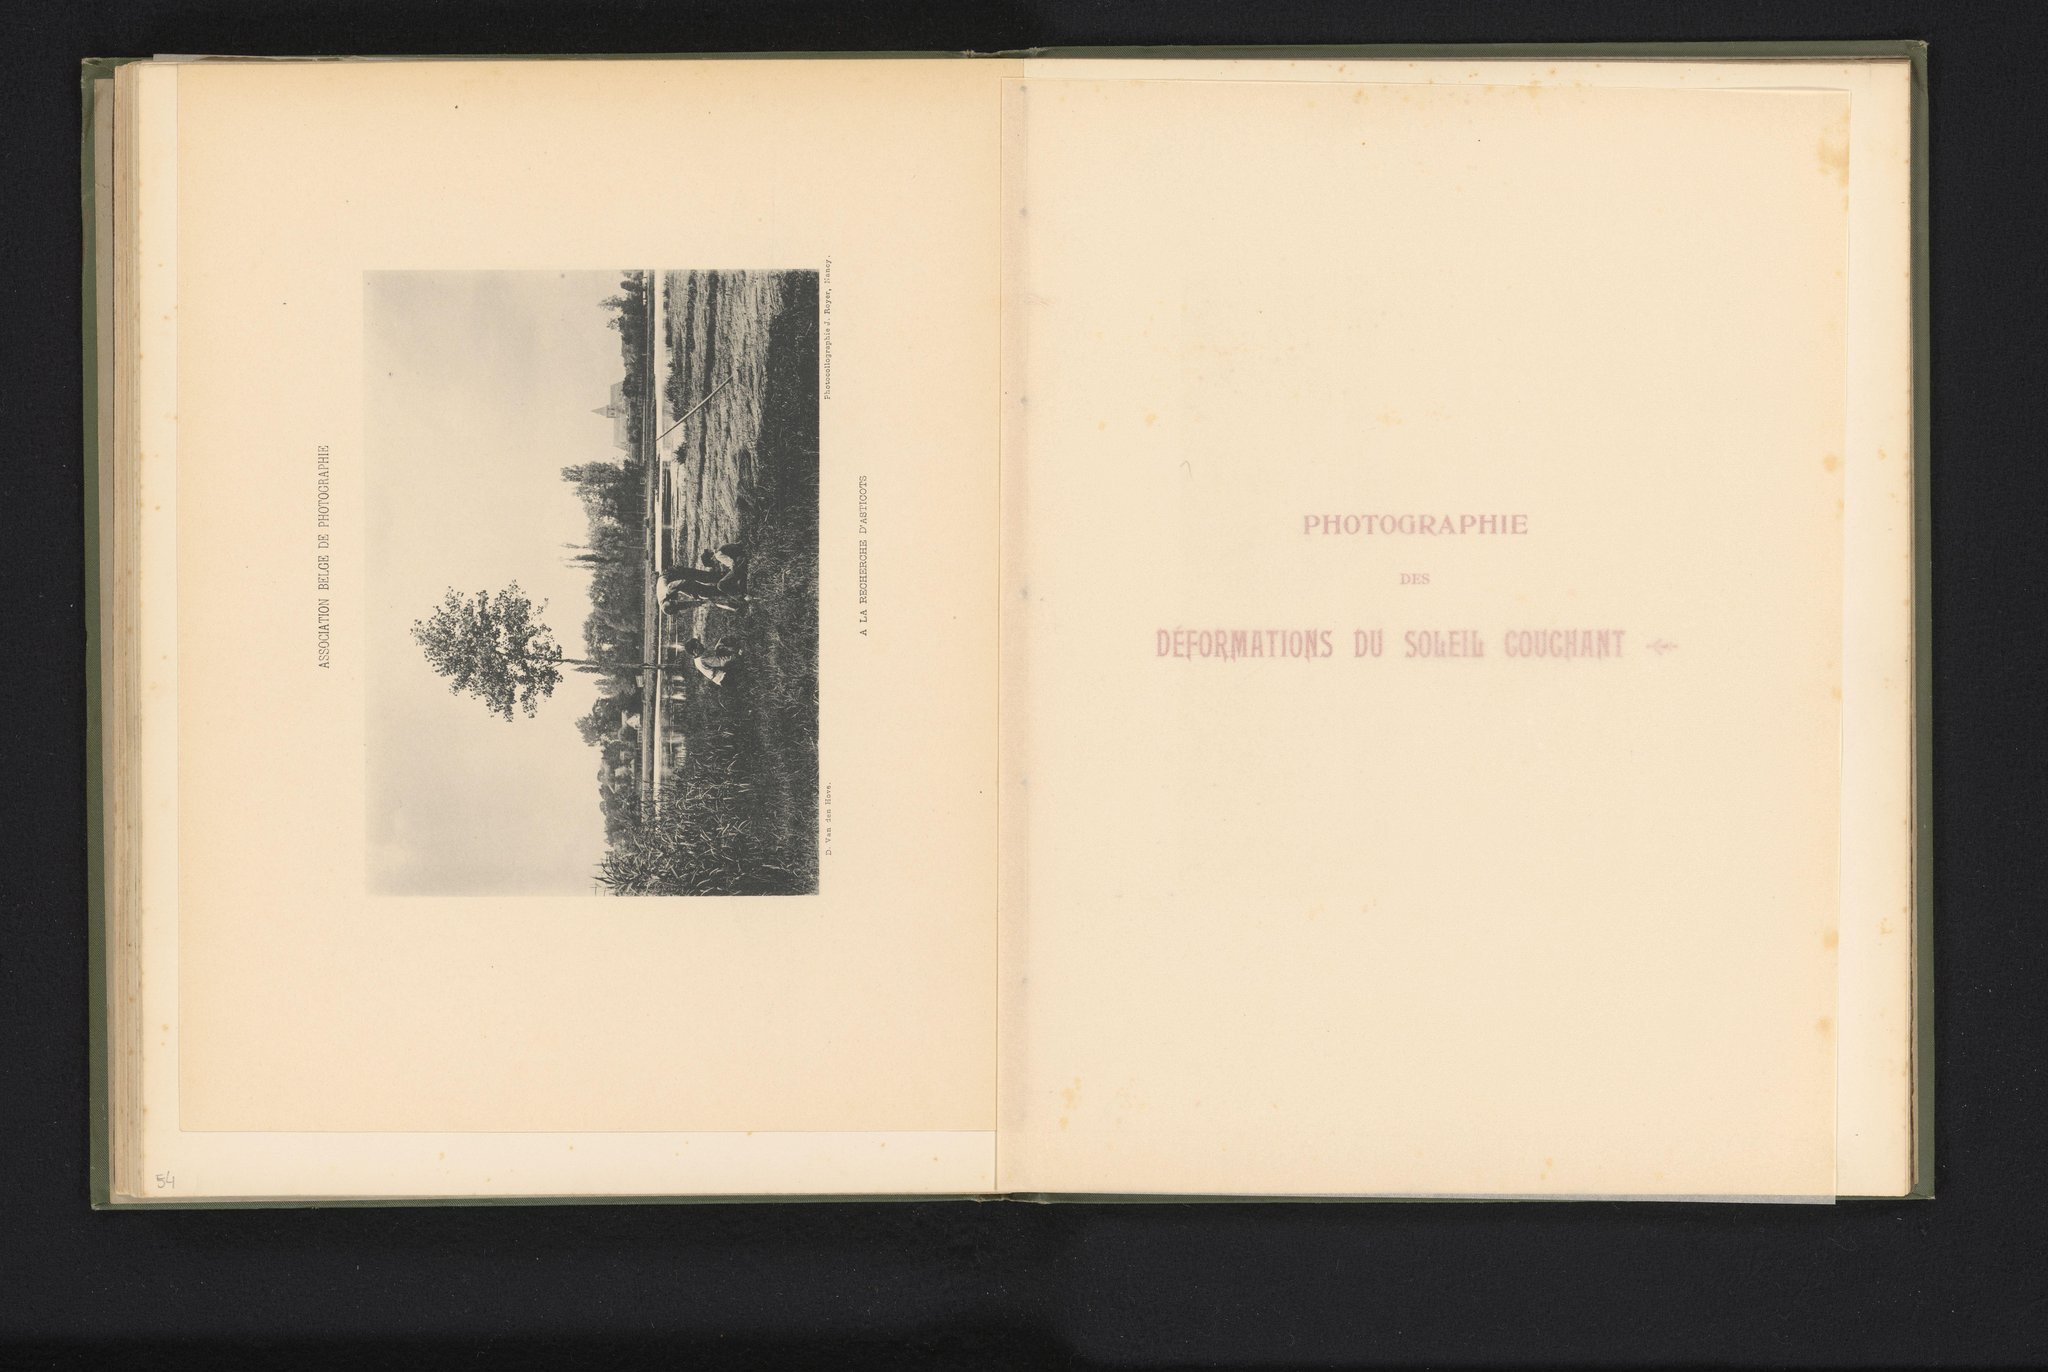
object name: photomechanical print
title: A la recherche d'asticots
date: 1893-1898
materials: paper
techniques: photograph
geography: nancy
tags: prospect of village, silhouette of village, boy (child between toddler and youth)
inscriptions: inscription: ‘Association Belge de photographie’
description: Prent op derde ongenummerde pagina na pagina 107.